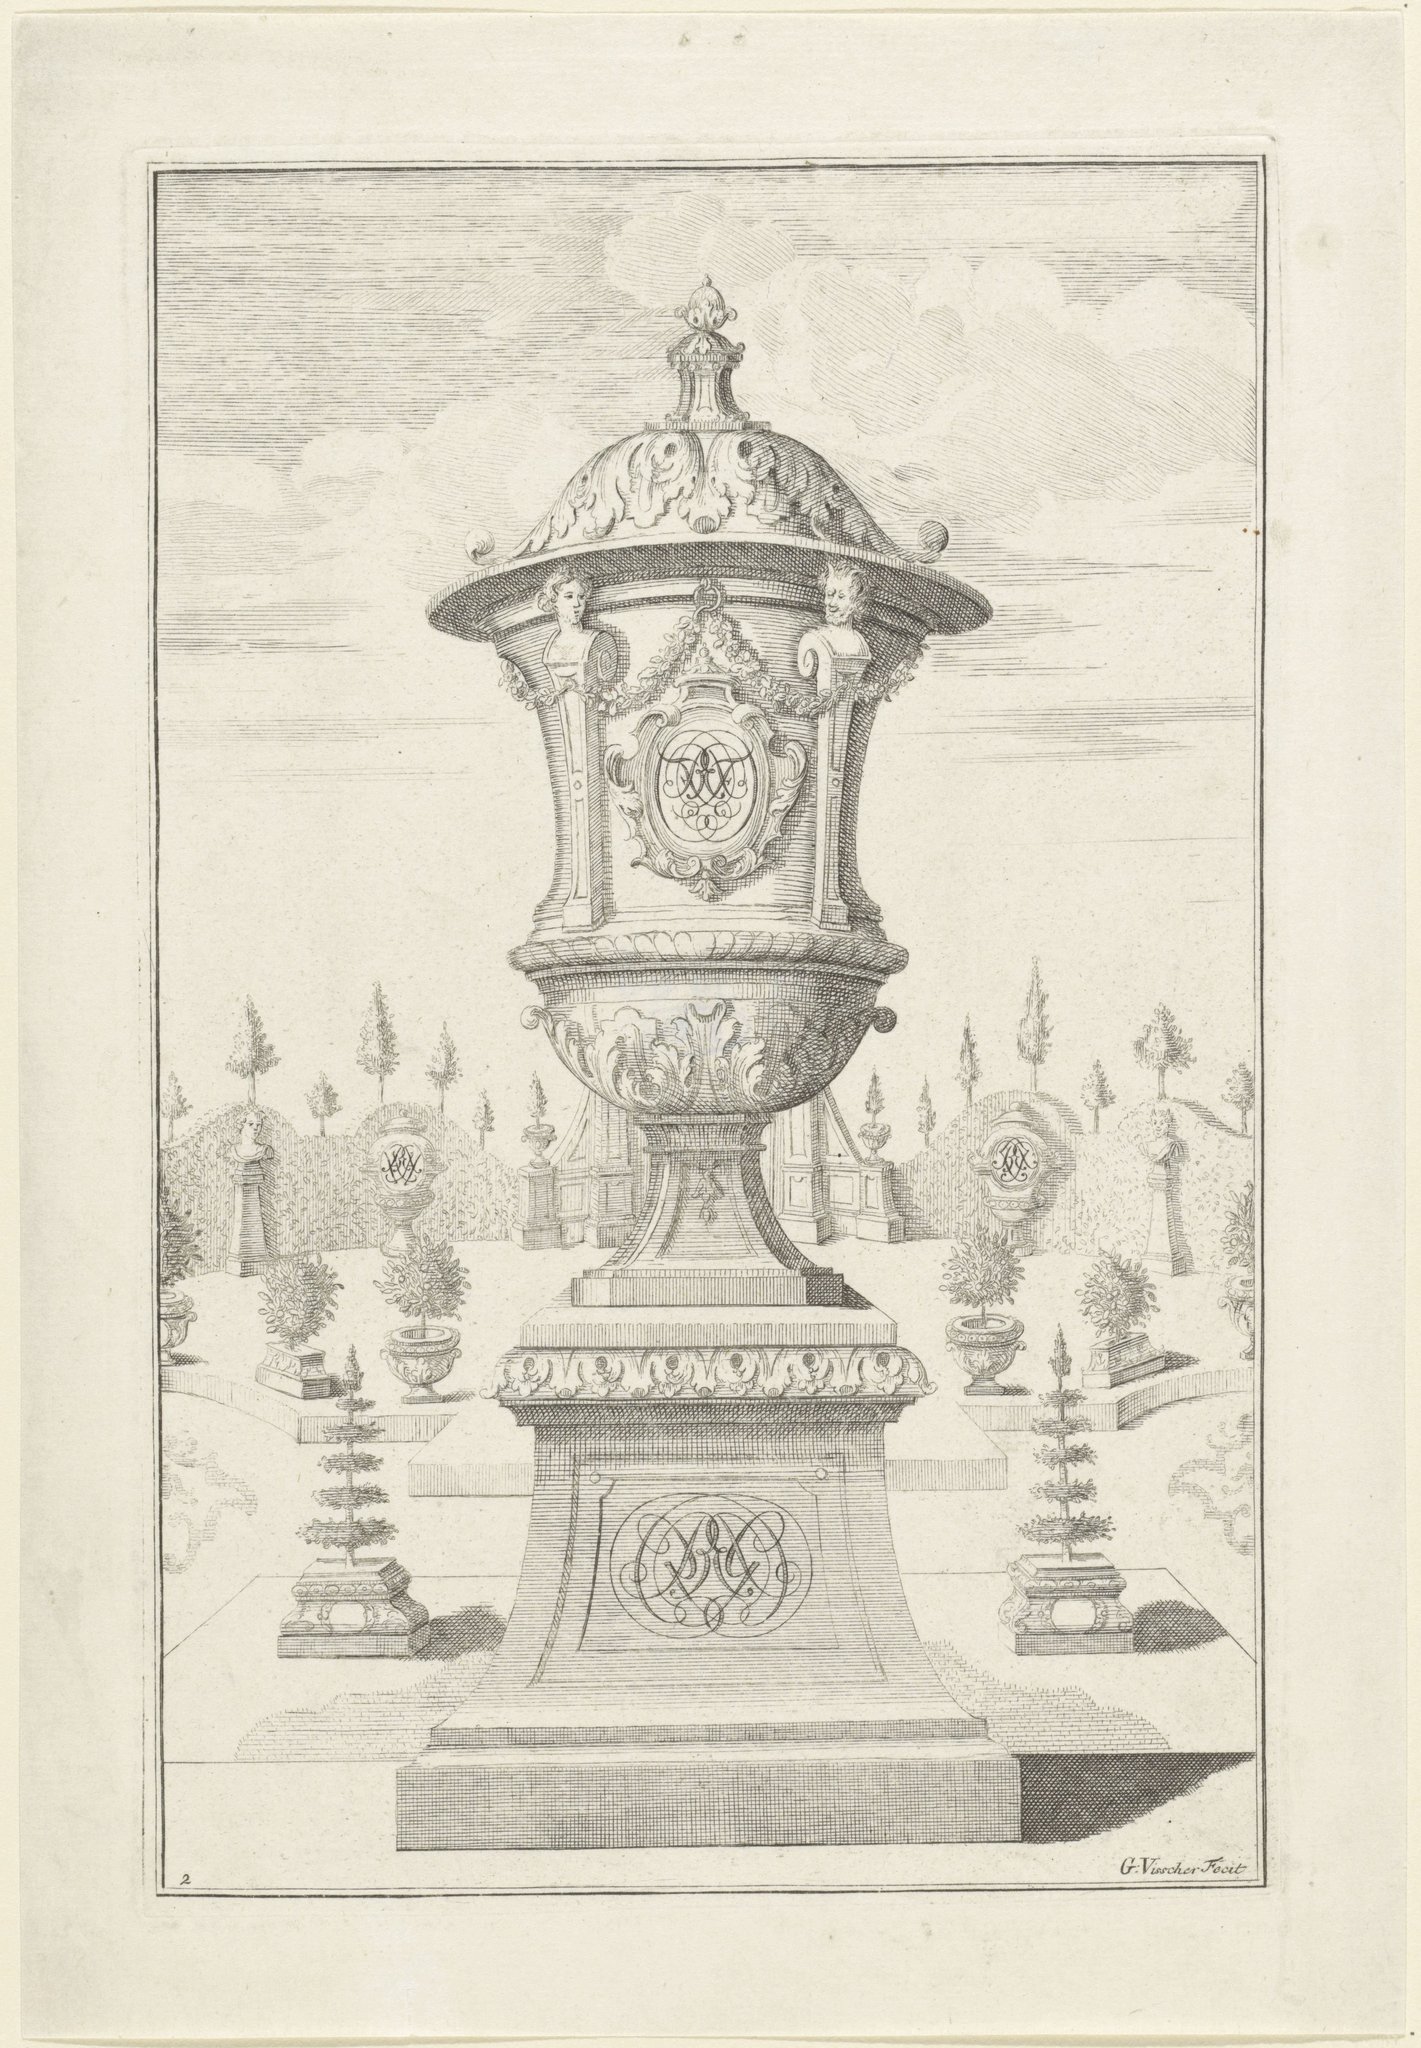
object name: print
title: Tuinvaas met monogram op voetstuk met monogram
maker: gerrit visscher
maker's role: print maker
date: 1690-1710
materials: paper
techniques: engraving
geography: amsterdam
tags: ornaments ~ art, garden vase, letter combinations such as letterword, anagram, letter square, monogram, etc.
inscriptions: collector's mark: Lugt 2228